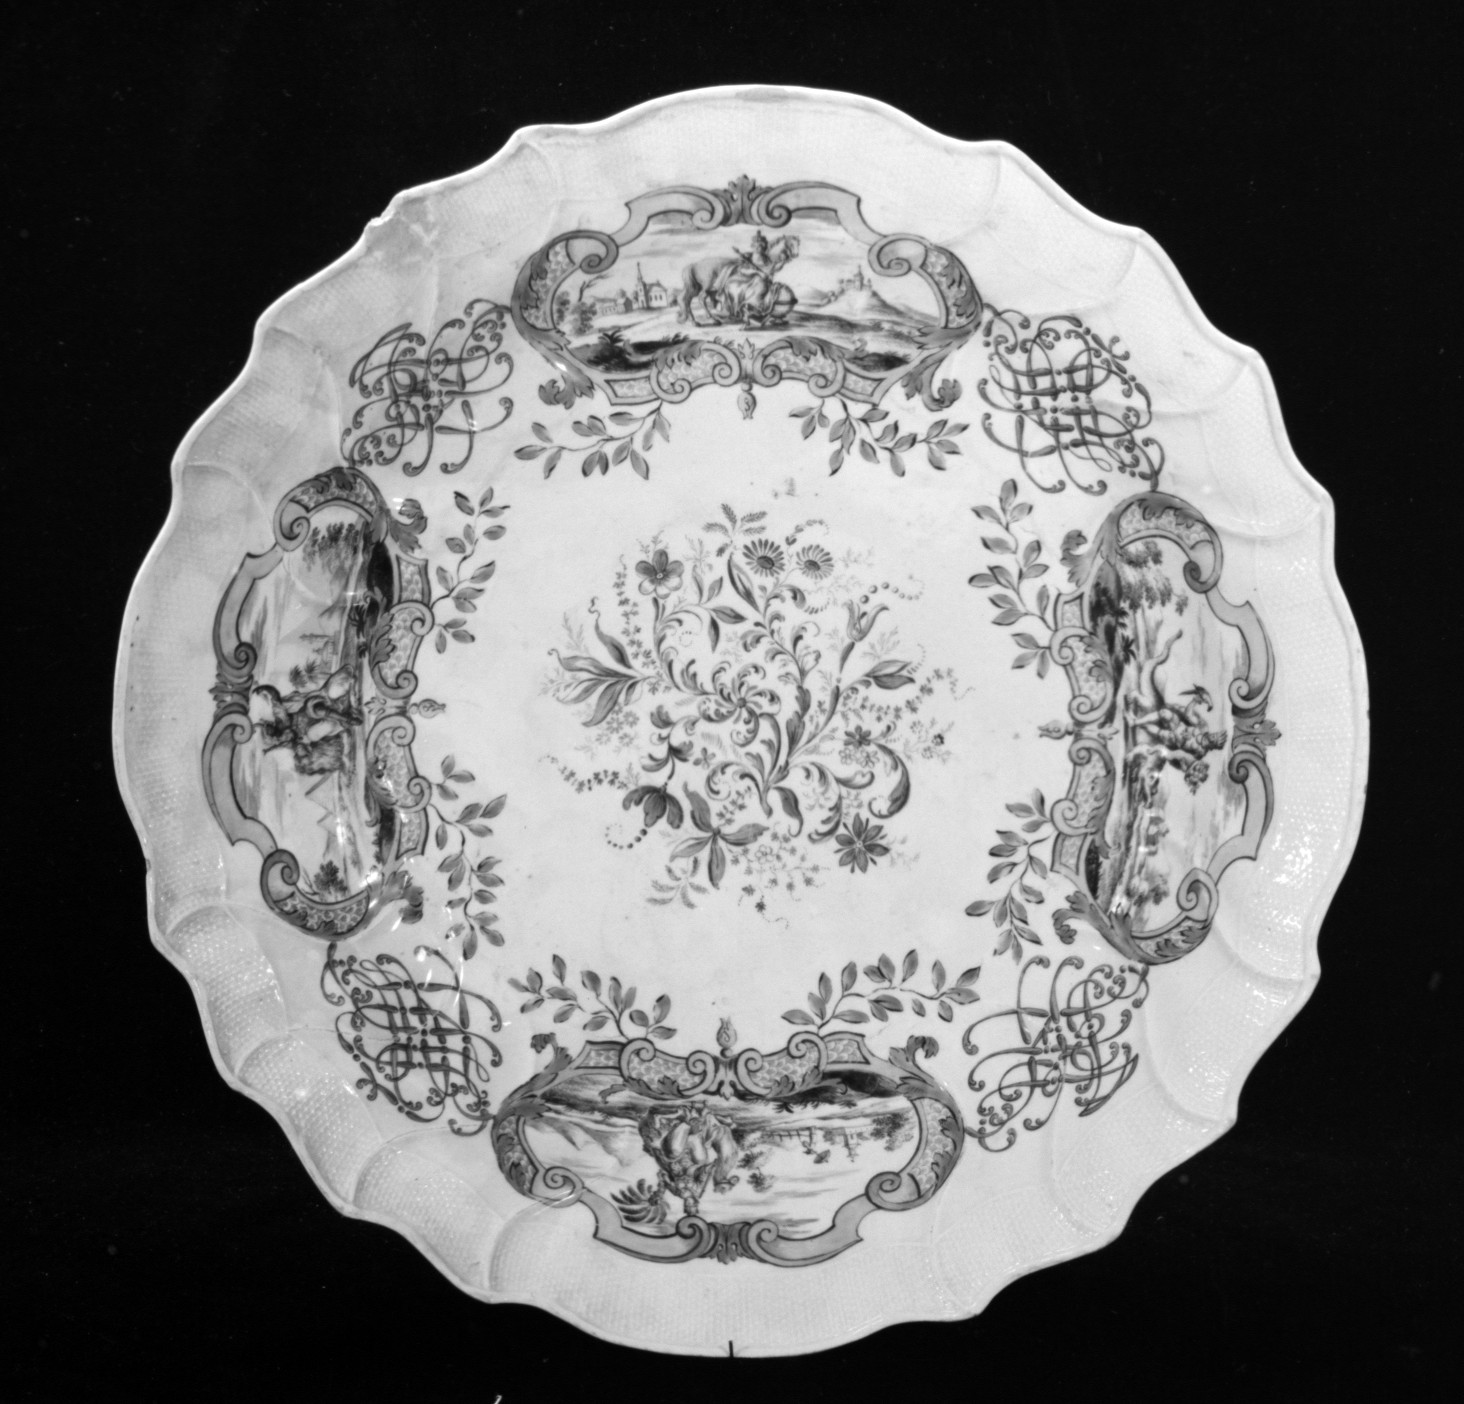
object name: dish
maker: meissen manufactory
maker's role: manufactory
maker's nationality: german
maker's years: 1710-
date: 1740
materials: hard paste porcelain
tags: flowers